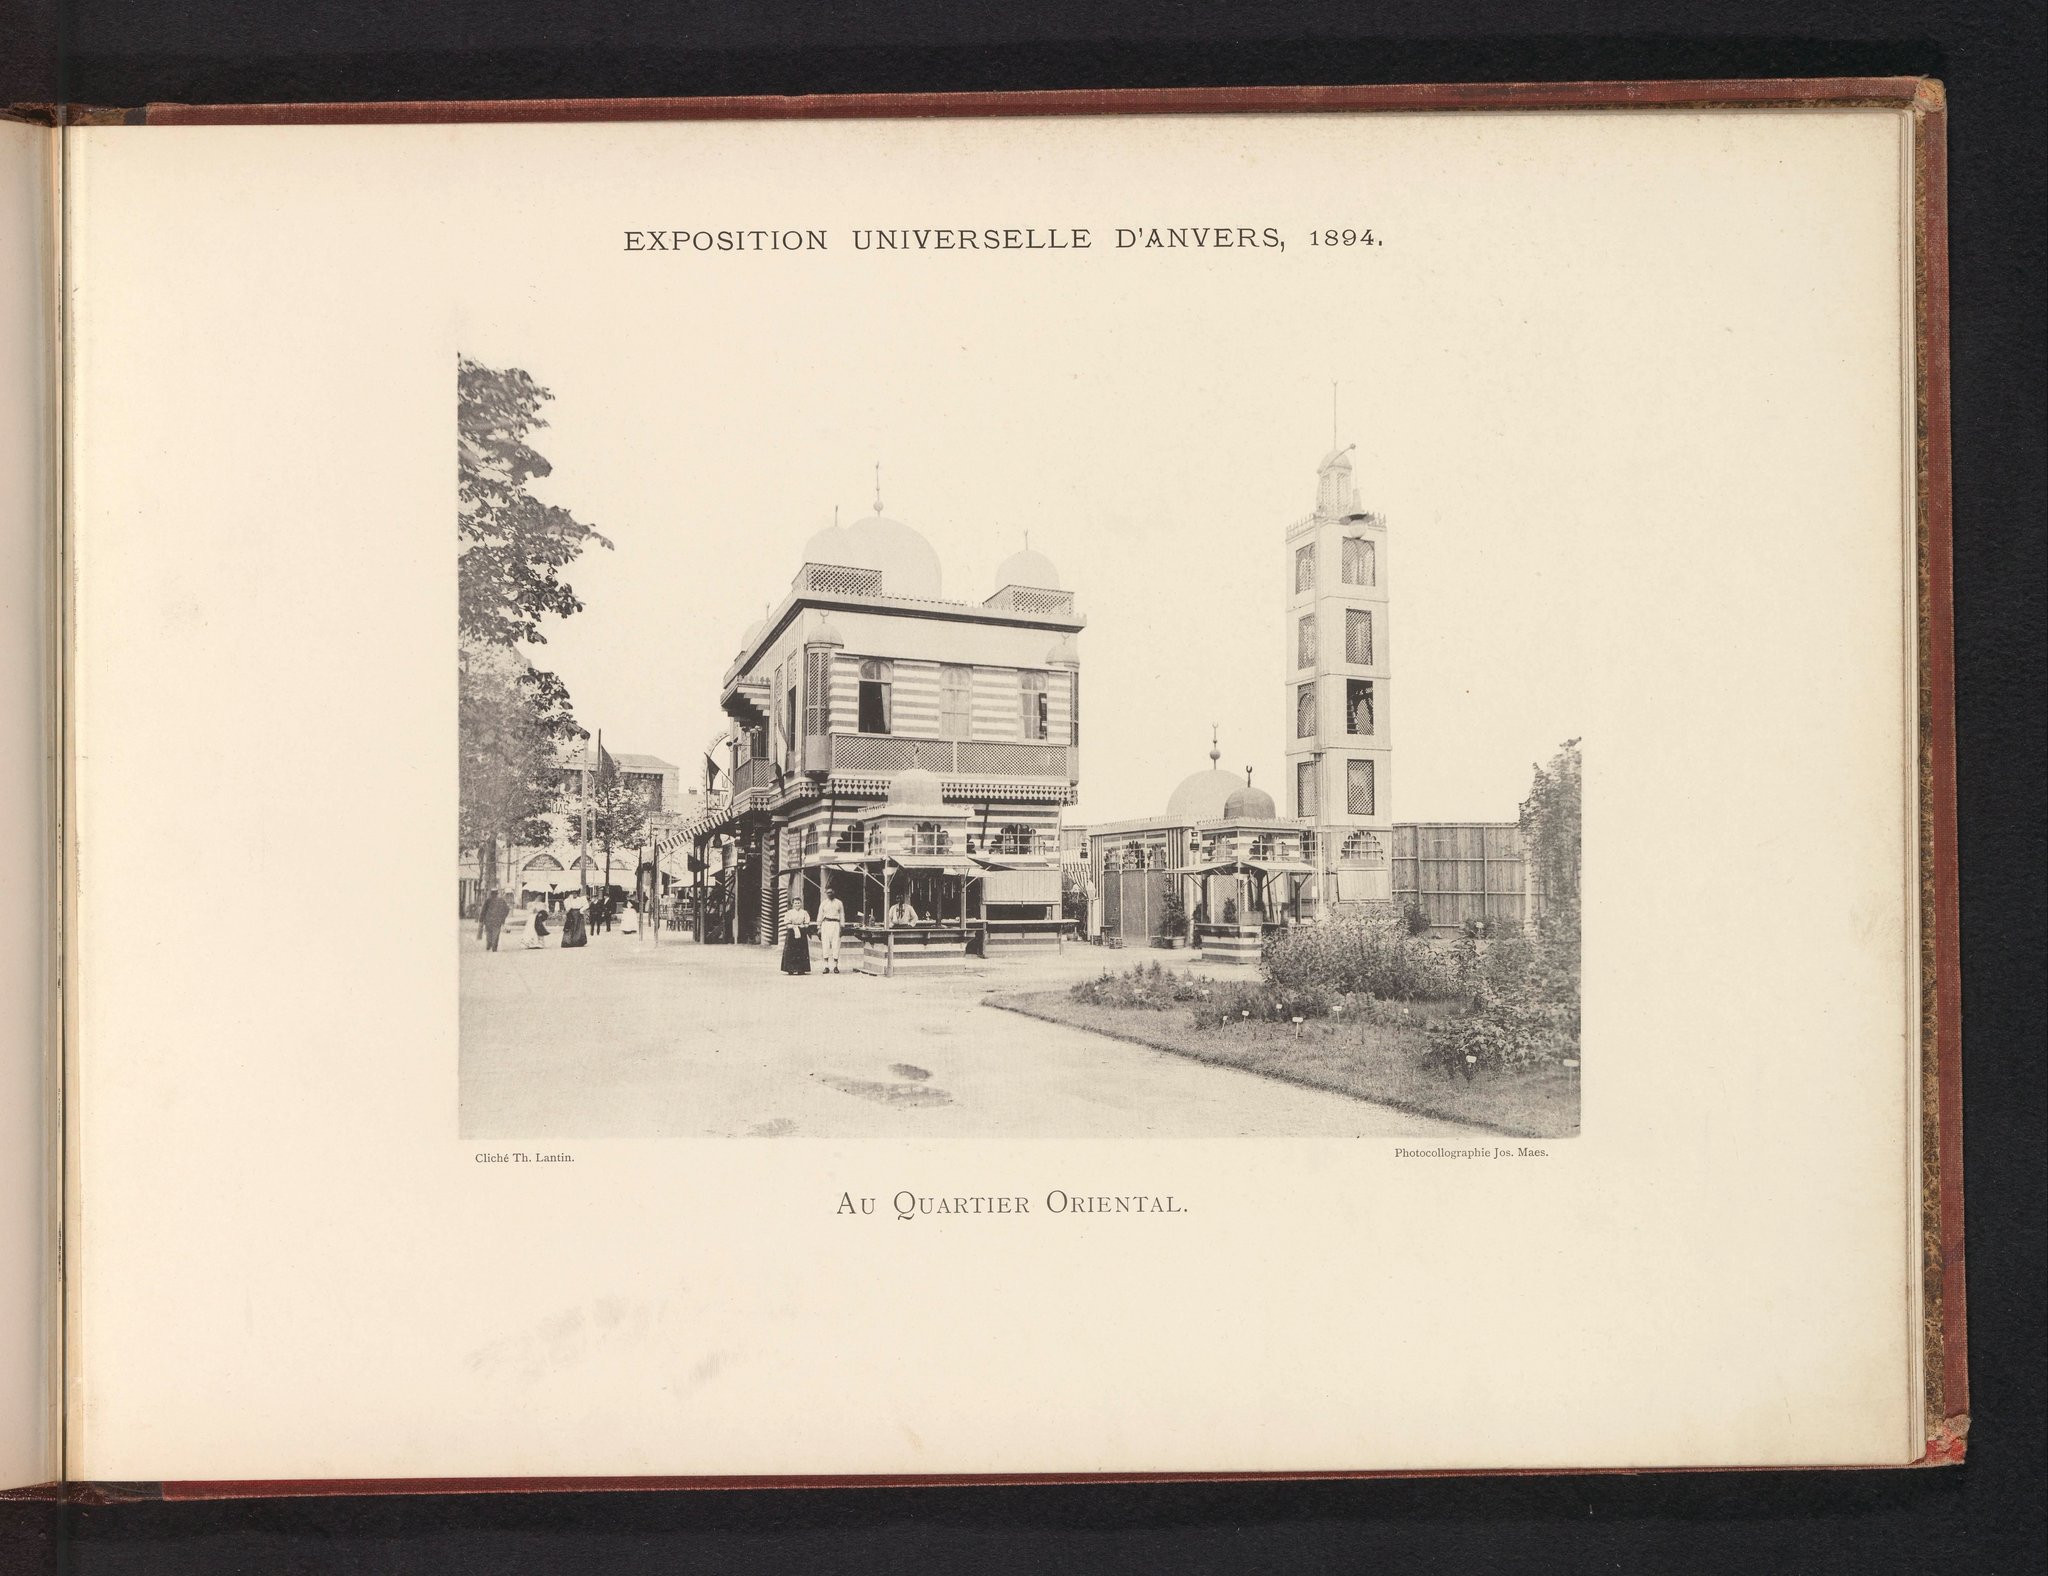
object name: photomechanical print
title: Exterieur van de Oriëntaalse sectie van de wereldtentoonstelling te Antwerpen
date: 1894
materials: paper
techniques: photograph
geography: antwerp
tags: world fair, world exhibition, façade (of house or building)